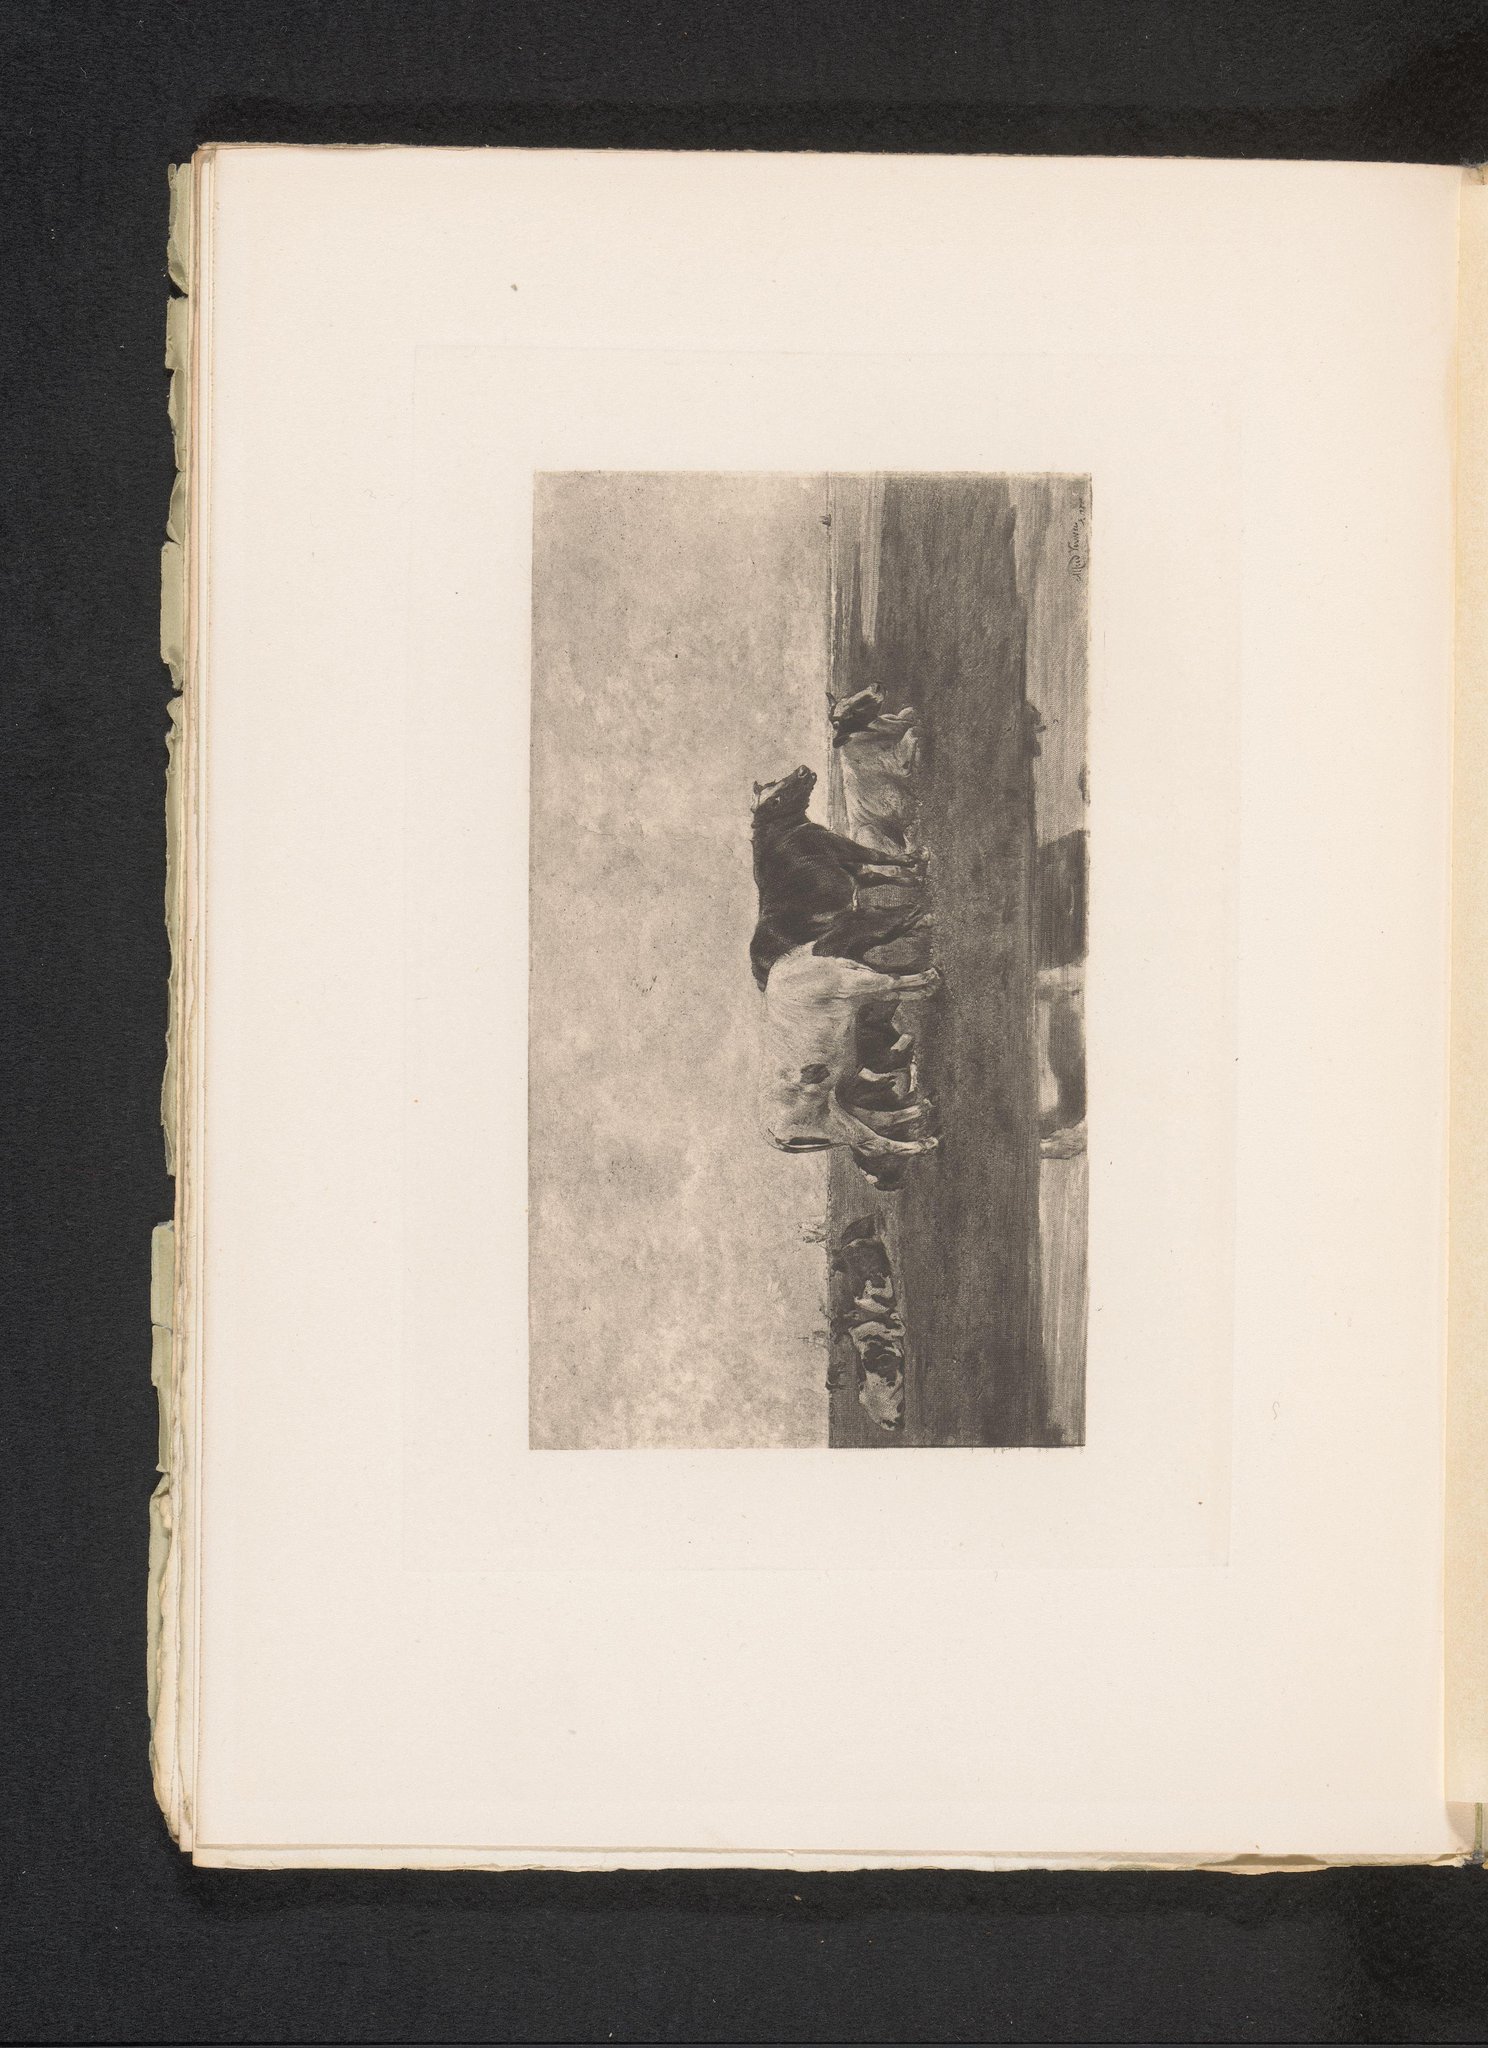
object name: reproduction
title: Fotoreproductie van L'Escaut à Austruweel door Alfred Verwée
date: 1879-1884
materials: paper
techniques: photoaquatint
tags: cow, painting, drawing and the graphic arts